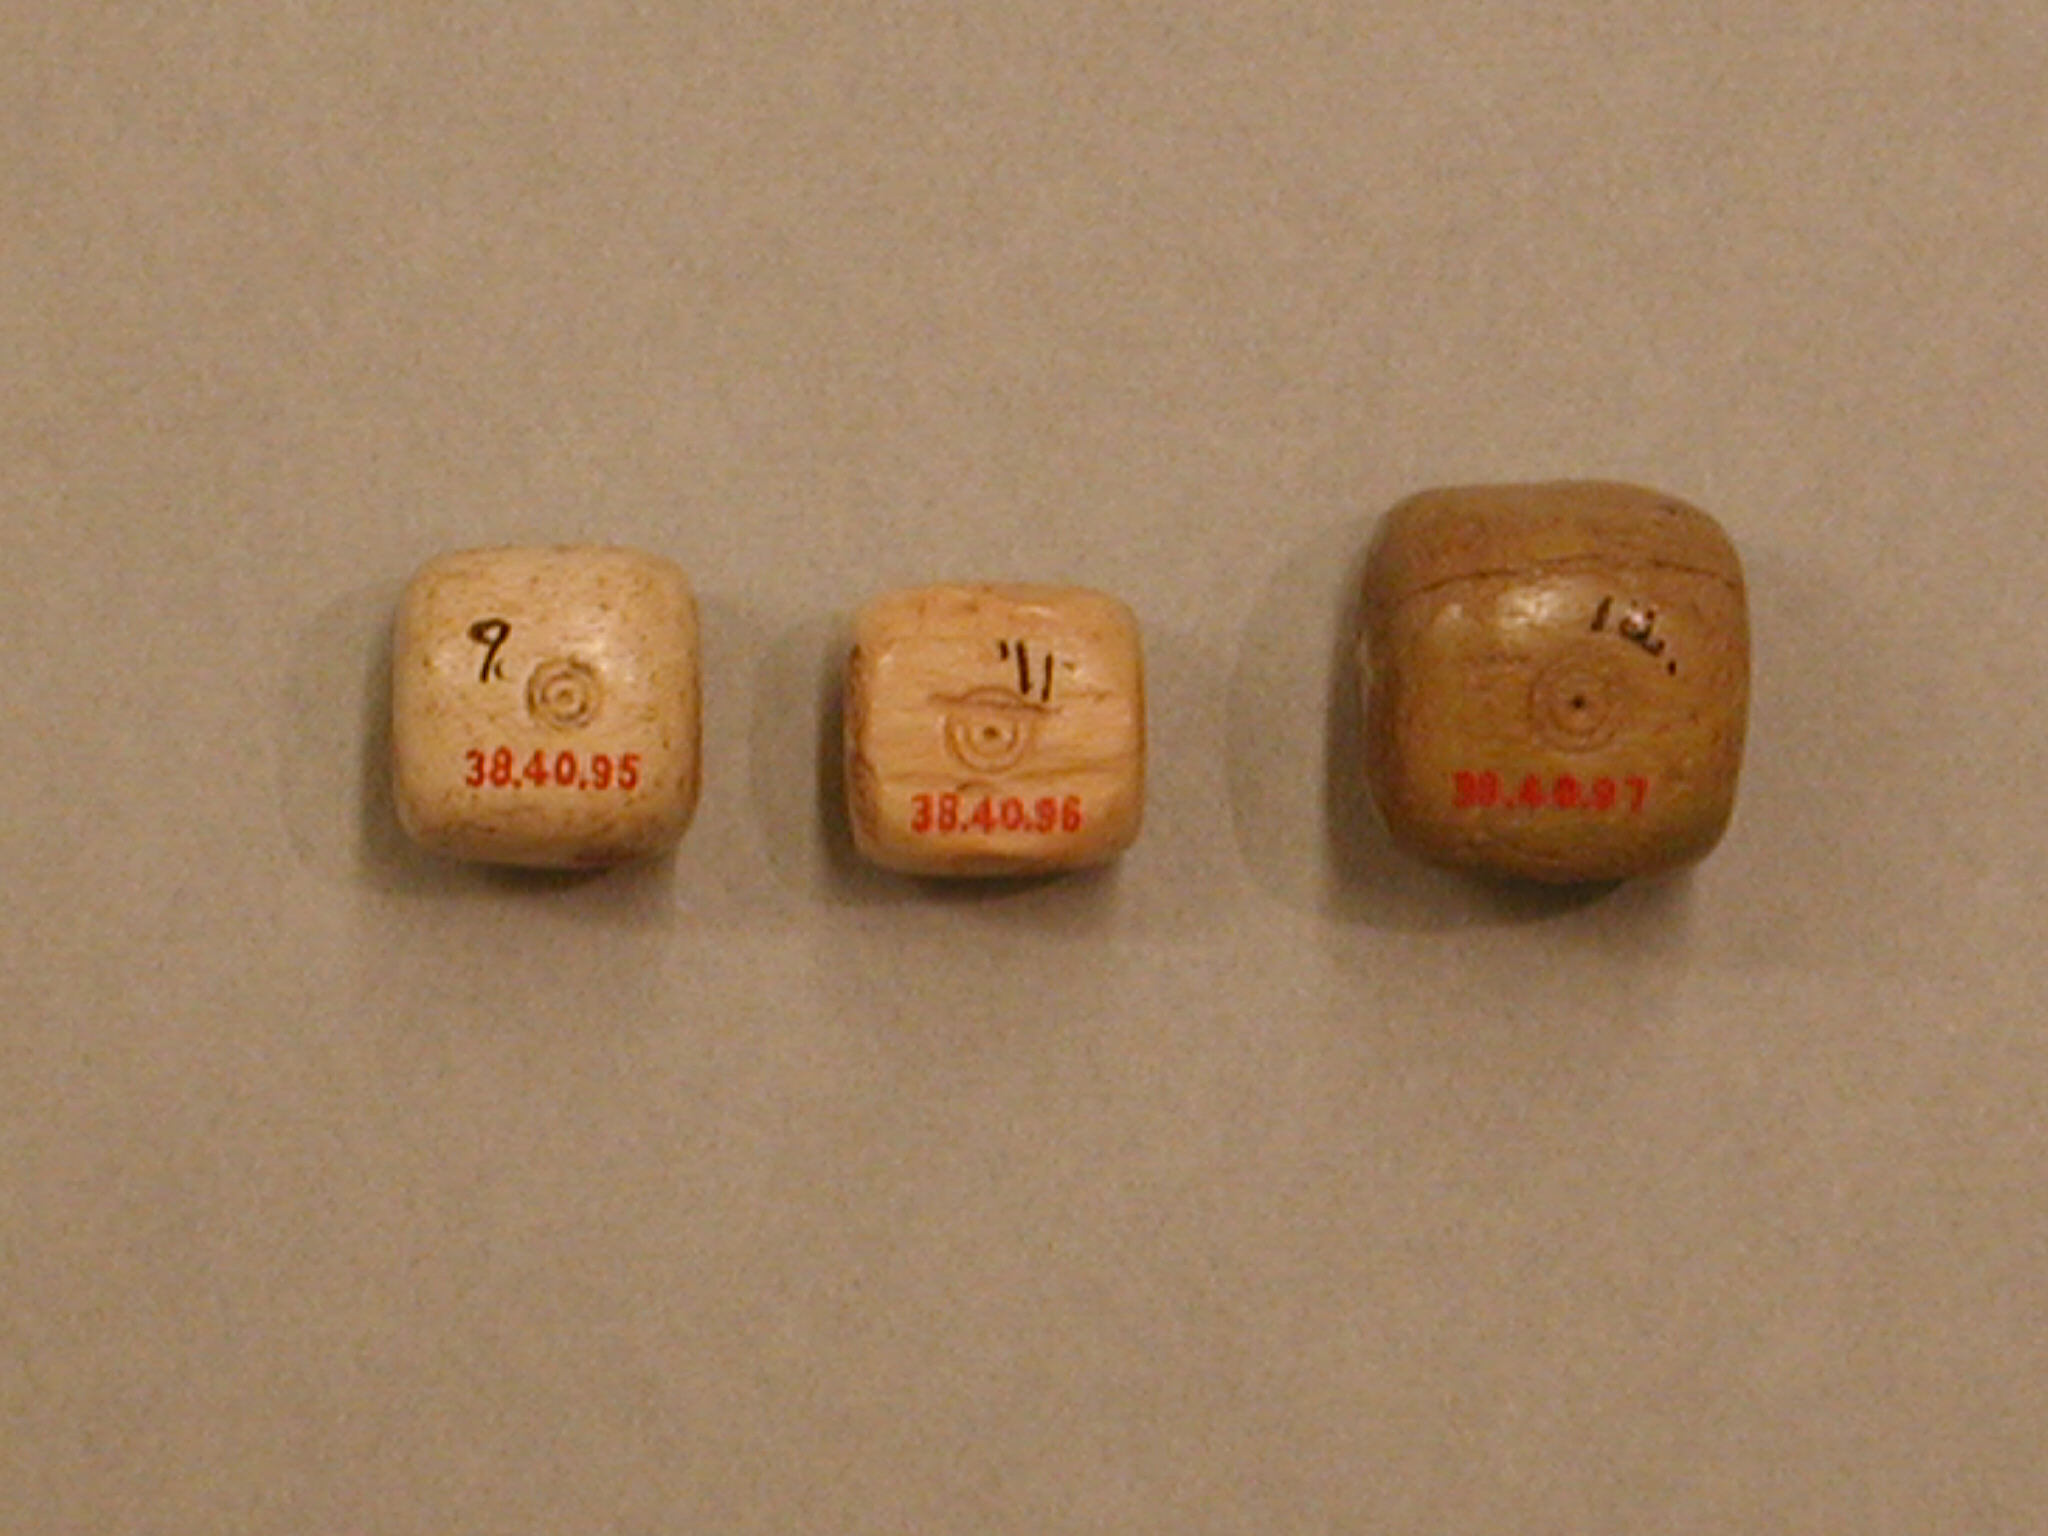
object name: dice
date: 801-1000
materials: bone, ivory, paint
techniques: incising, inlay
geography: iran